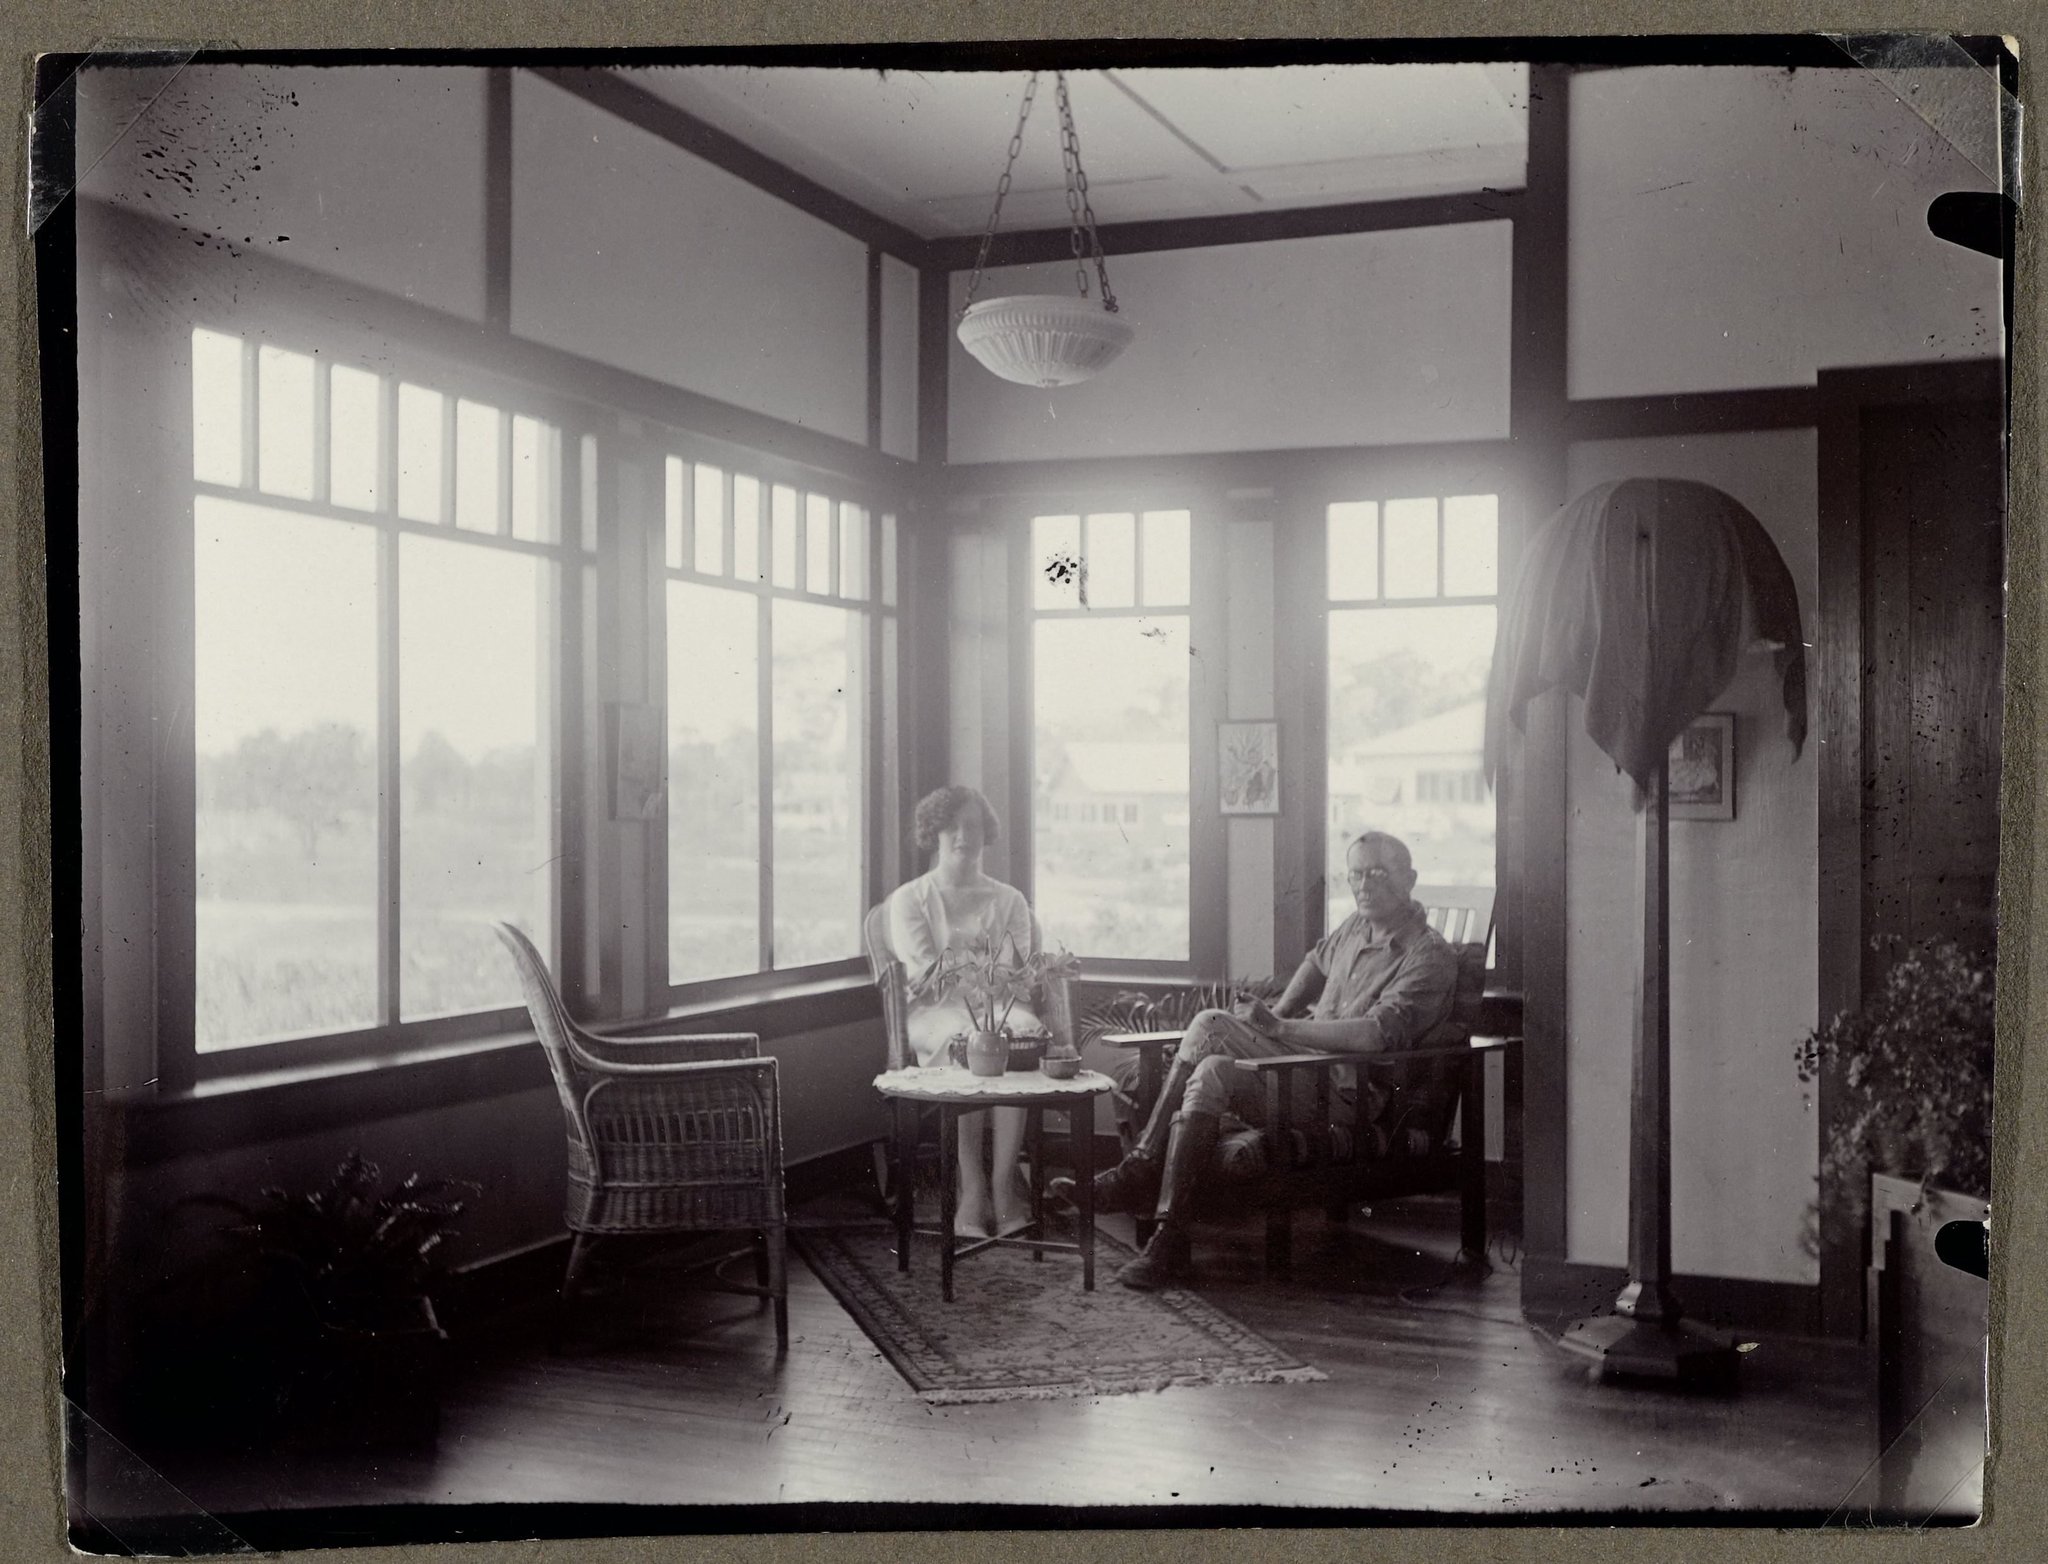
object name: photograph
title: Echtpaar Jetten in hun woonkamer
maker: Anonymous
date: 1925-1927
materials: photographic support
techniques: photography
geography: suriname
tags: interior of the house, suriname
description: Het echtpaar Jetten zittend in de woonkamer van hun huis te Moengo. Foto met hoekjes bevestigd op een bladzijde van een albumblad in het fotoalbum over de familie Jetten en het leven en werken in de mijnstad Moengo in Suriname rond 1927.